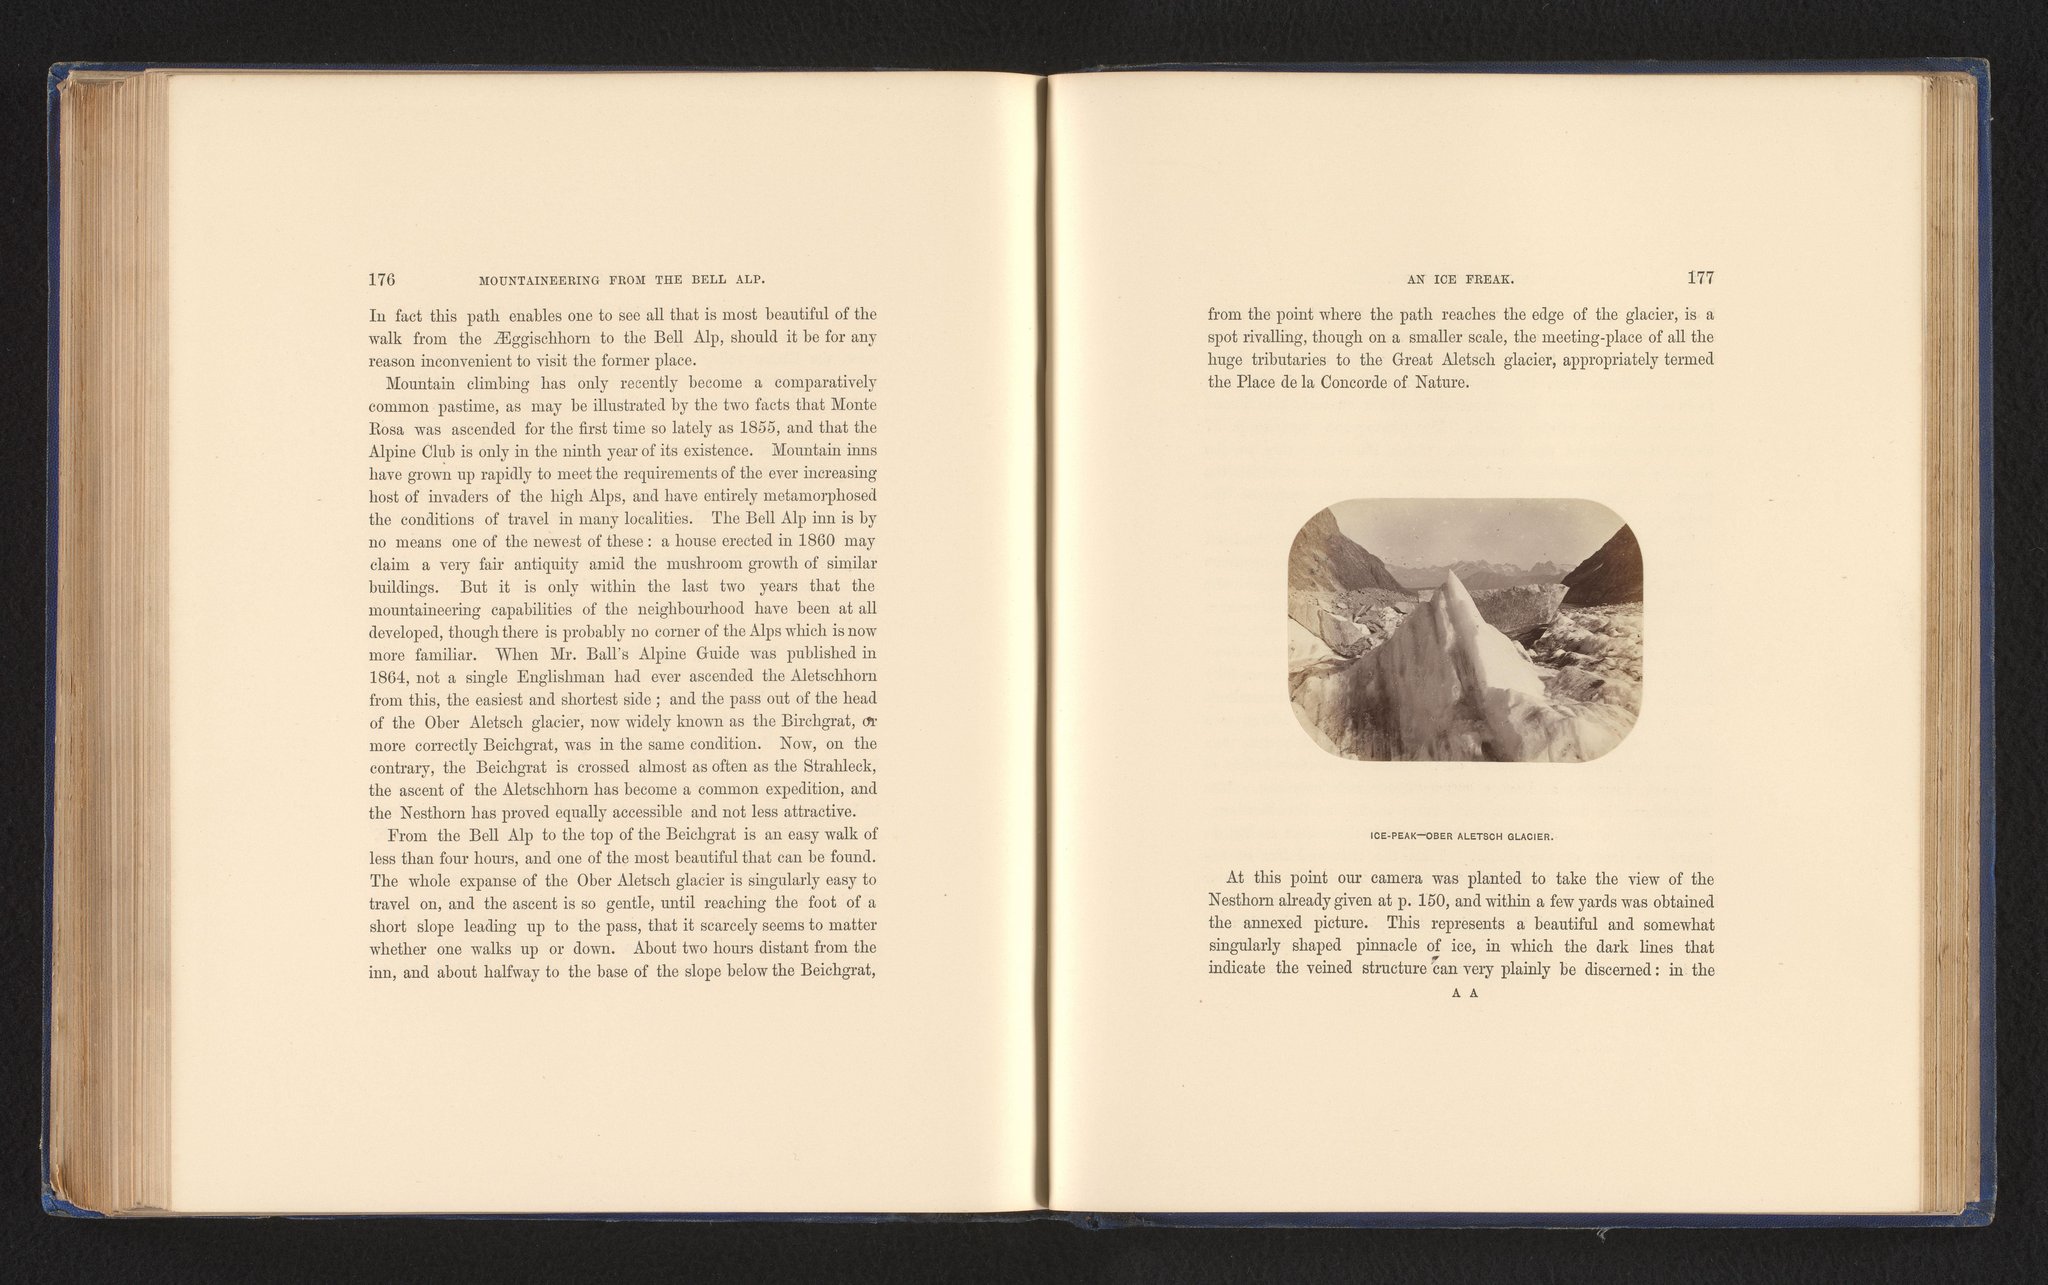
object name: photograph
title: Ice-peak - Ober Aletsch glacier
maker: ernest edwards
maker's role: fotograaf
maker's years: 1837-1903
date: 1861-1866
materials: paper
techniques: albumen print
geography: berner alpen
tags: glacier